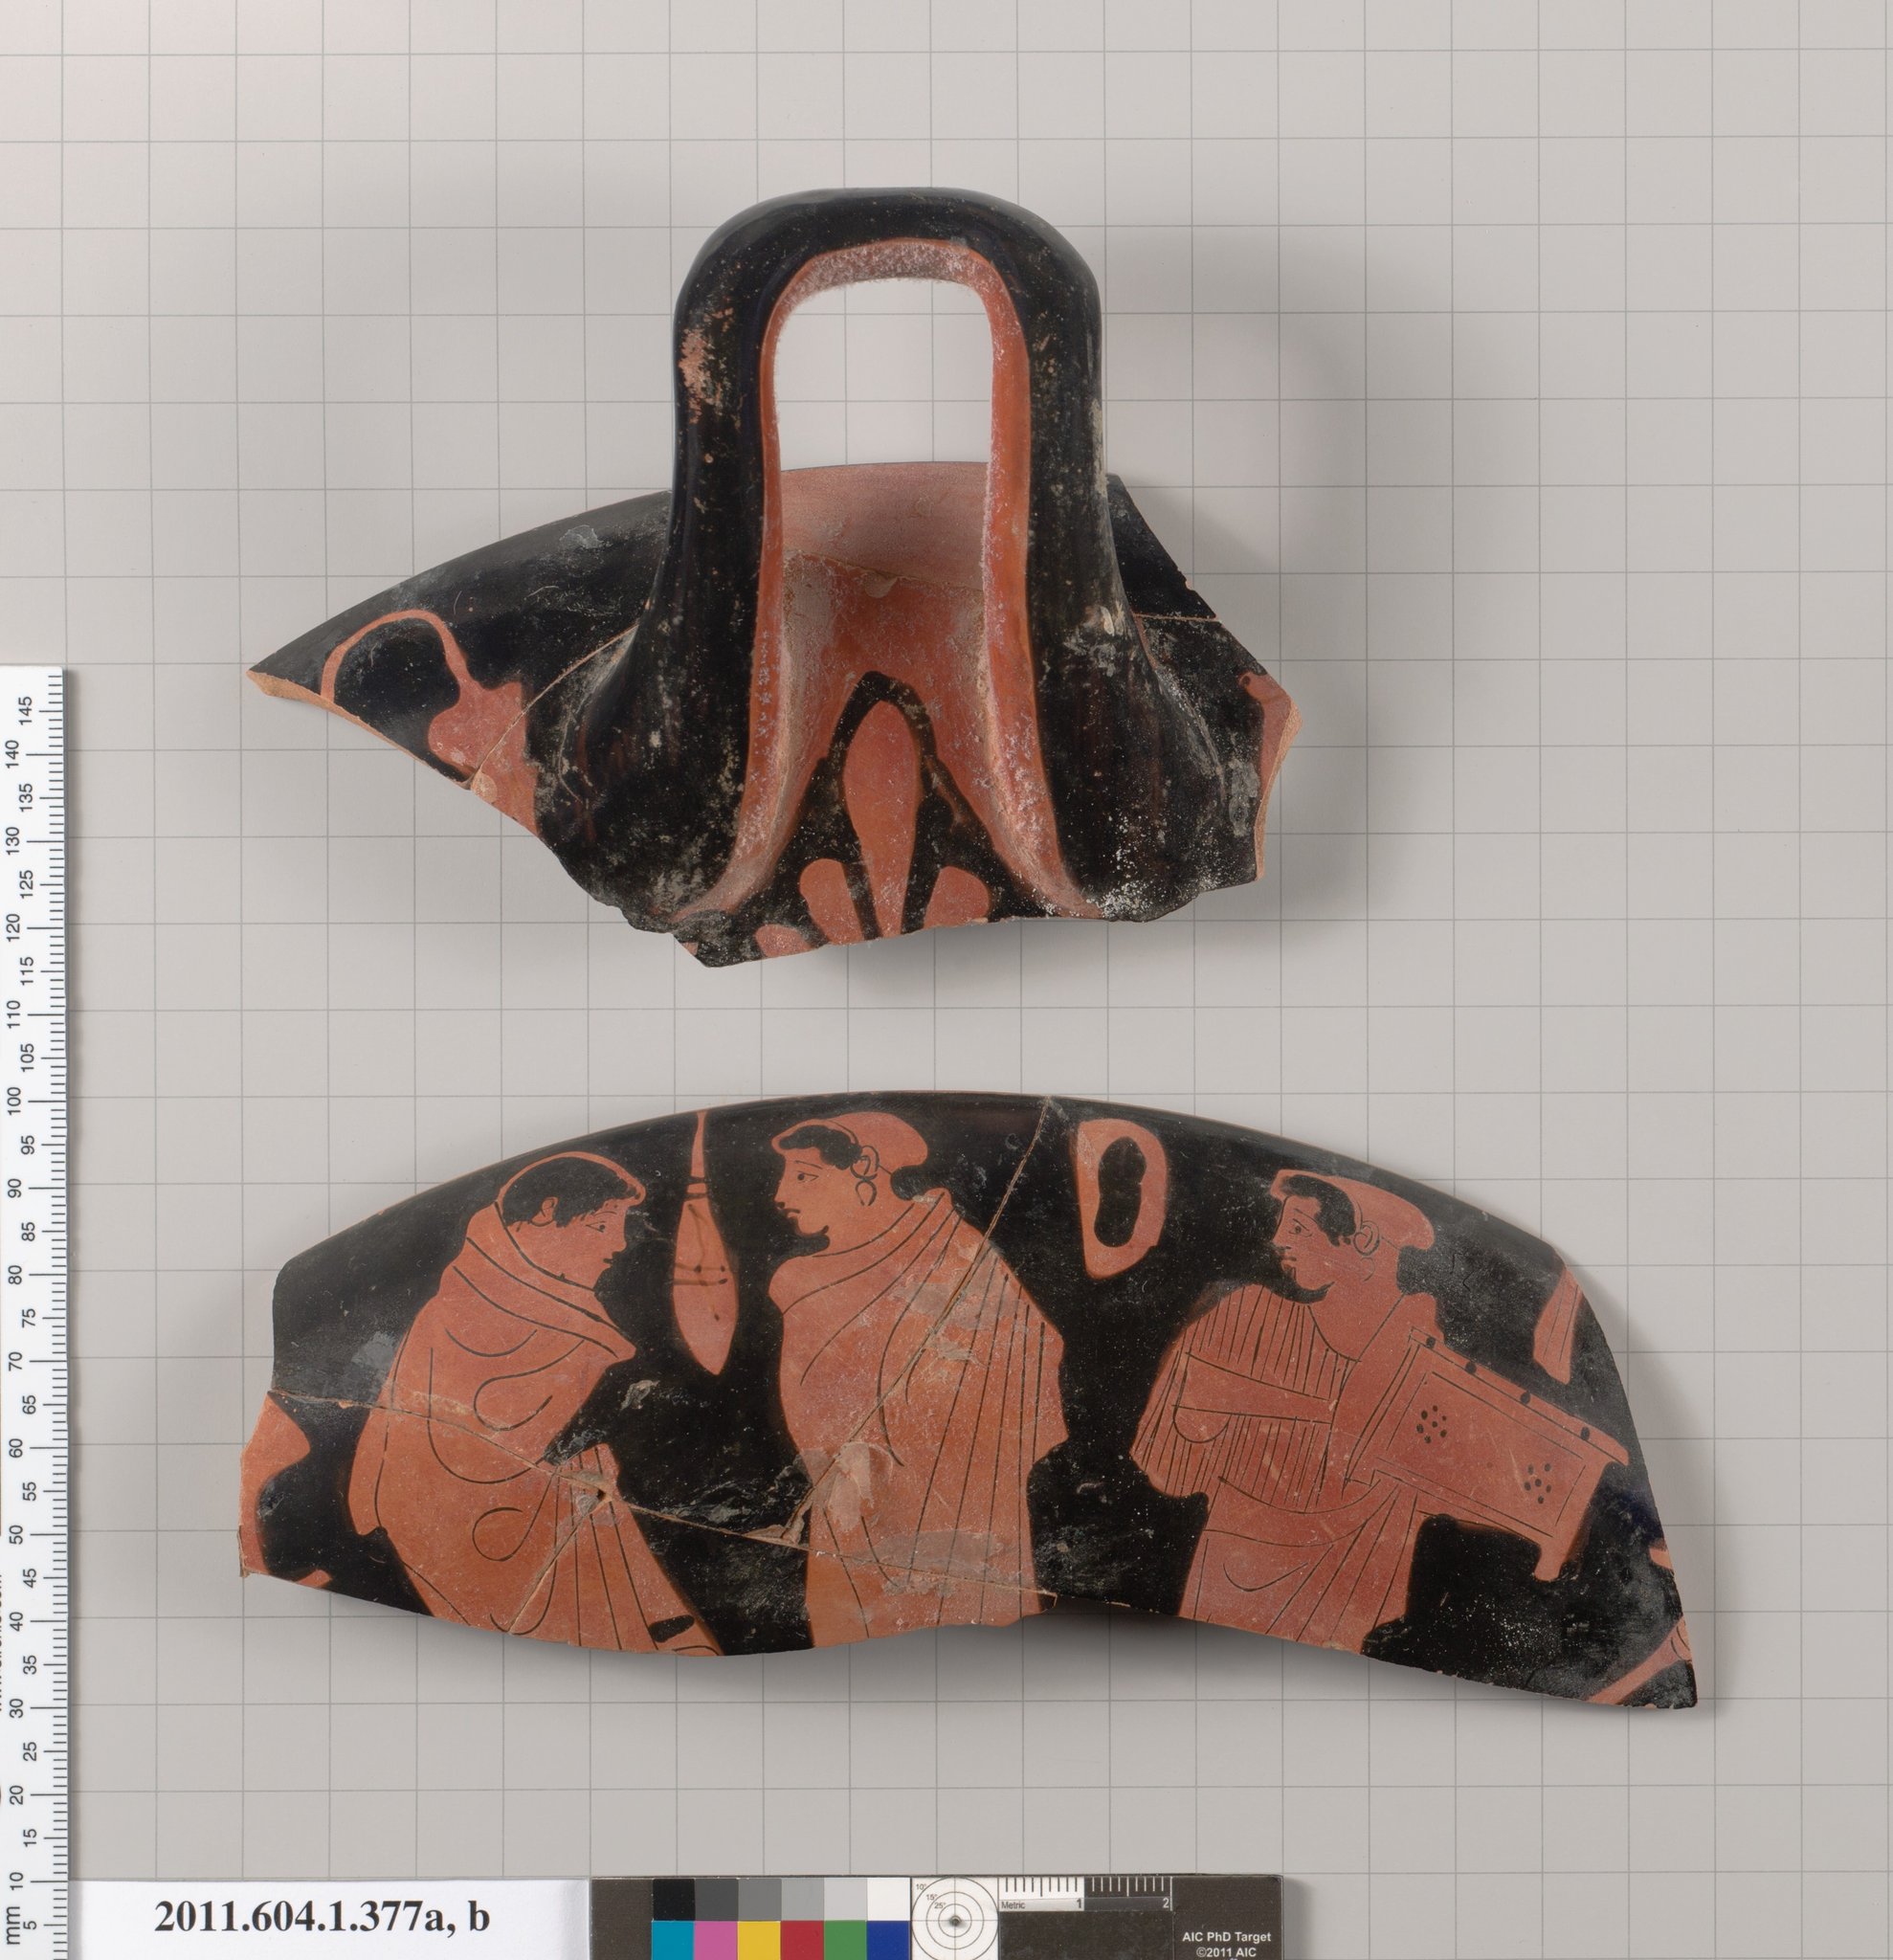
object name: kylix fragment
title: Terracotta fragments of a kylix (drinking cup)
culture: greek, attic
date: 467-435 BCE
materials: terracotta